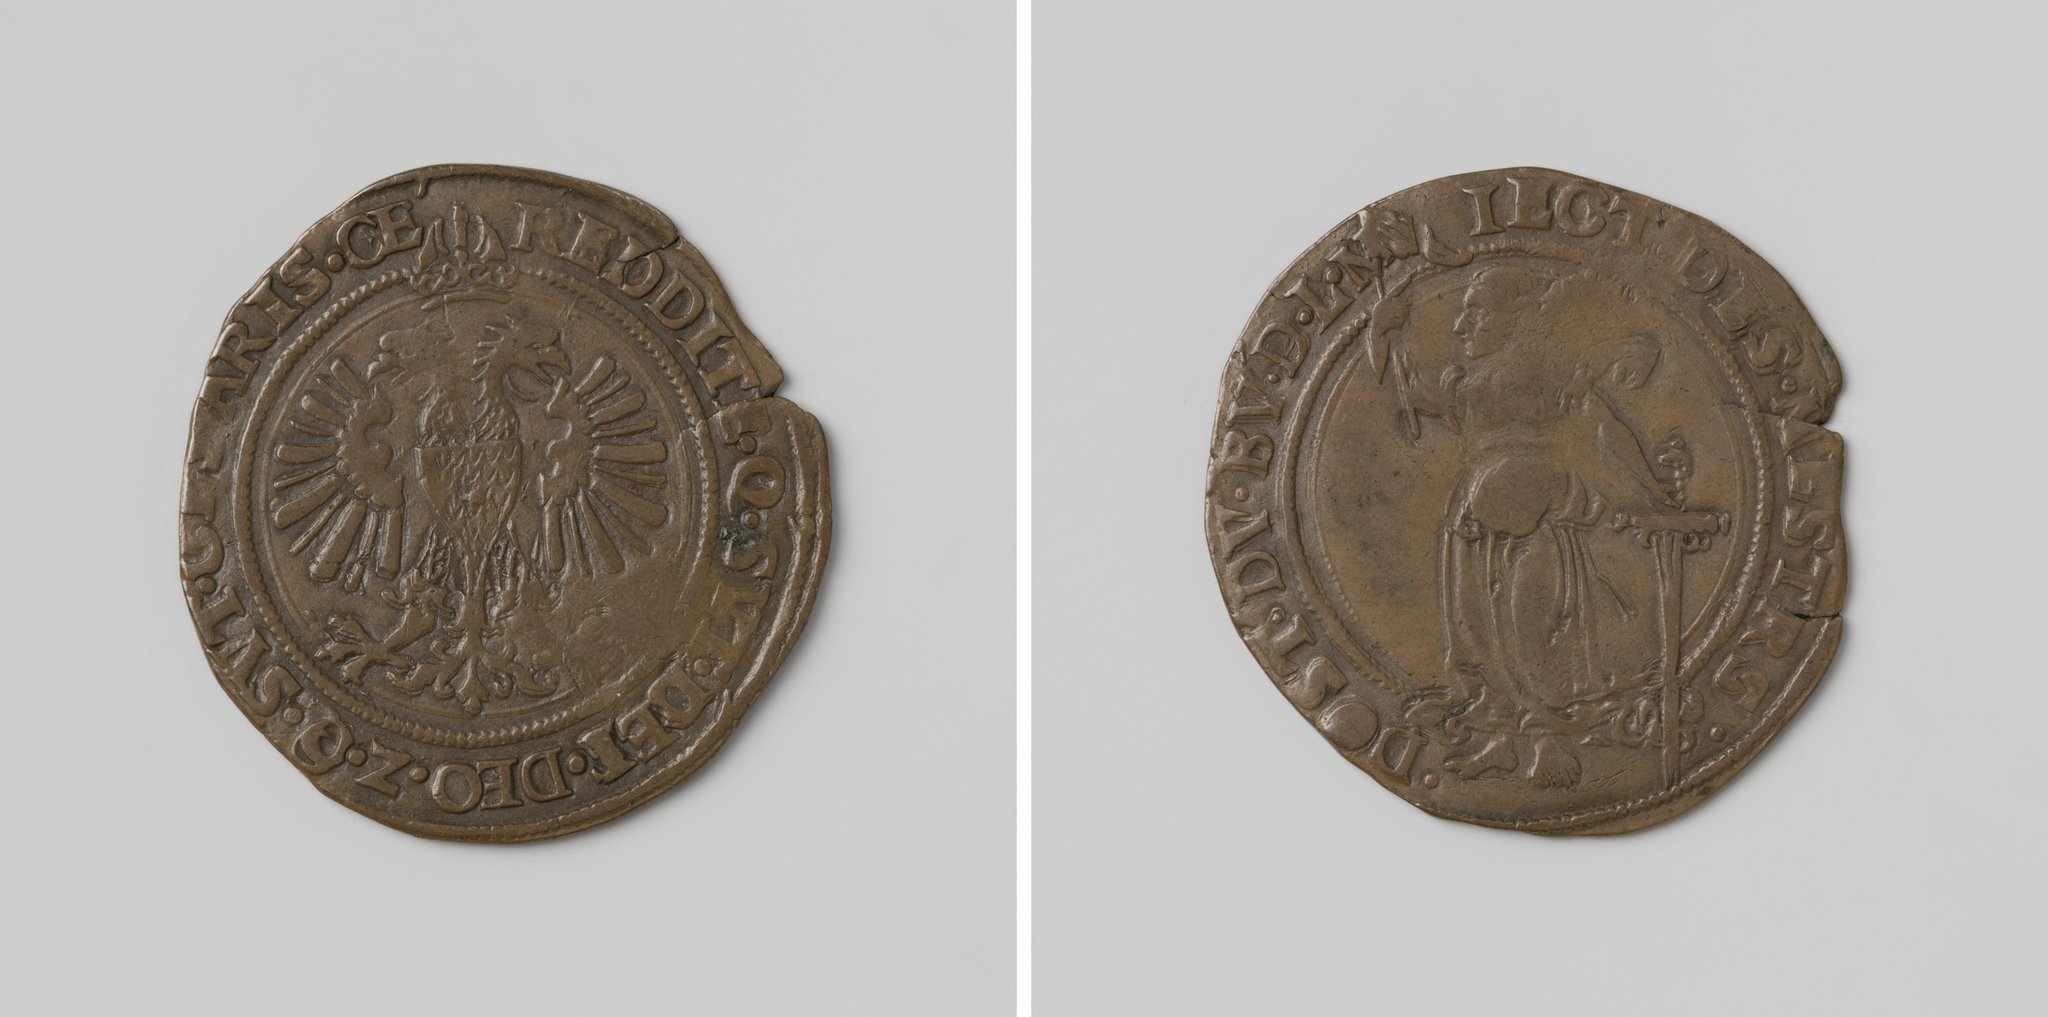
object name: jeton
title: Neerslaan van de opstand te Gent, rekenpenning van de raad van Financiën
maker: Anonymous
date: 1540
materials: copper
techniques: striking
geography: belgium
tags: ghent, charles v (holy roman emperor and king of spain)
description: Koperen penning. Voorzijde: tweekoppige adelaar onder kroon binnen omschrift. Keerzijde: vrouw met vaandel in geheven rechter- en zwaard in linkerhand binnen omschrift